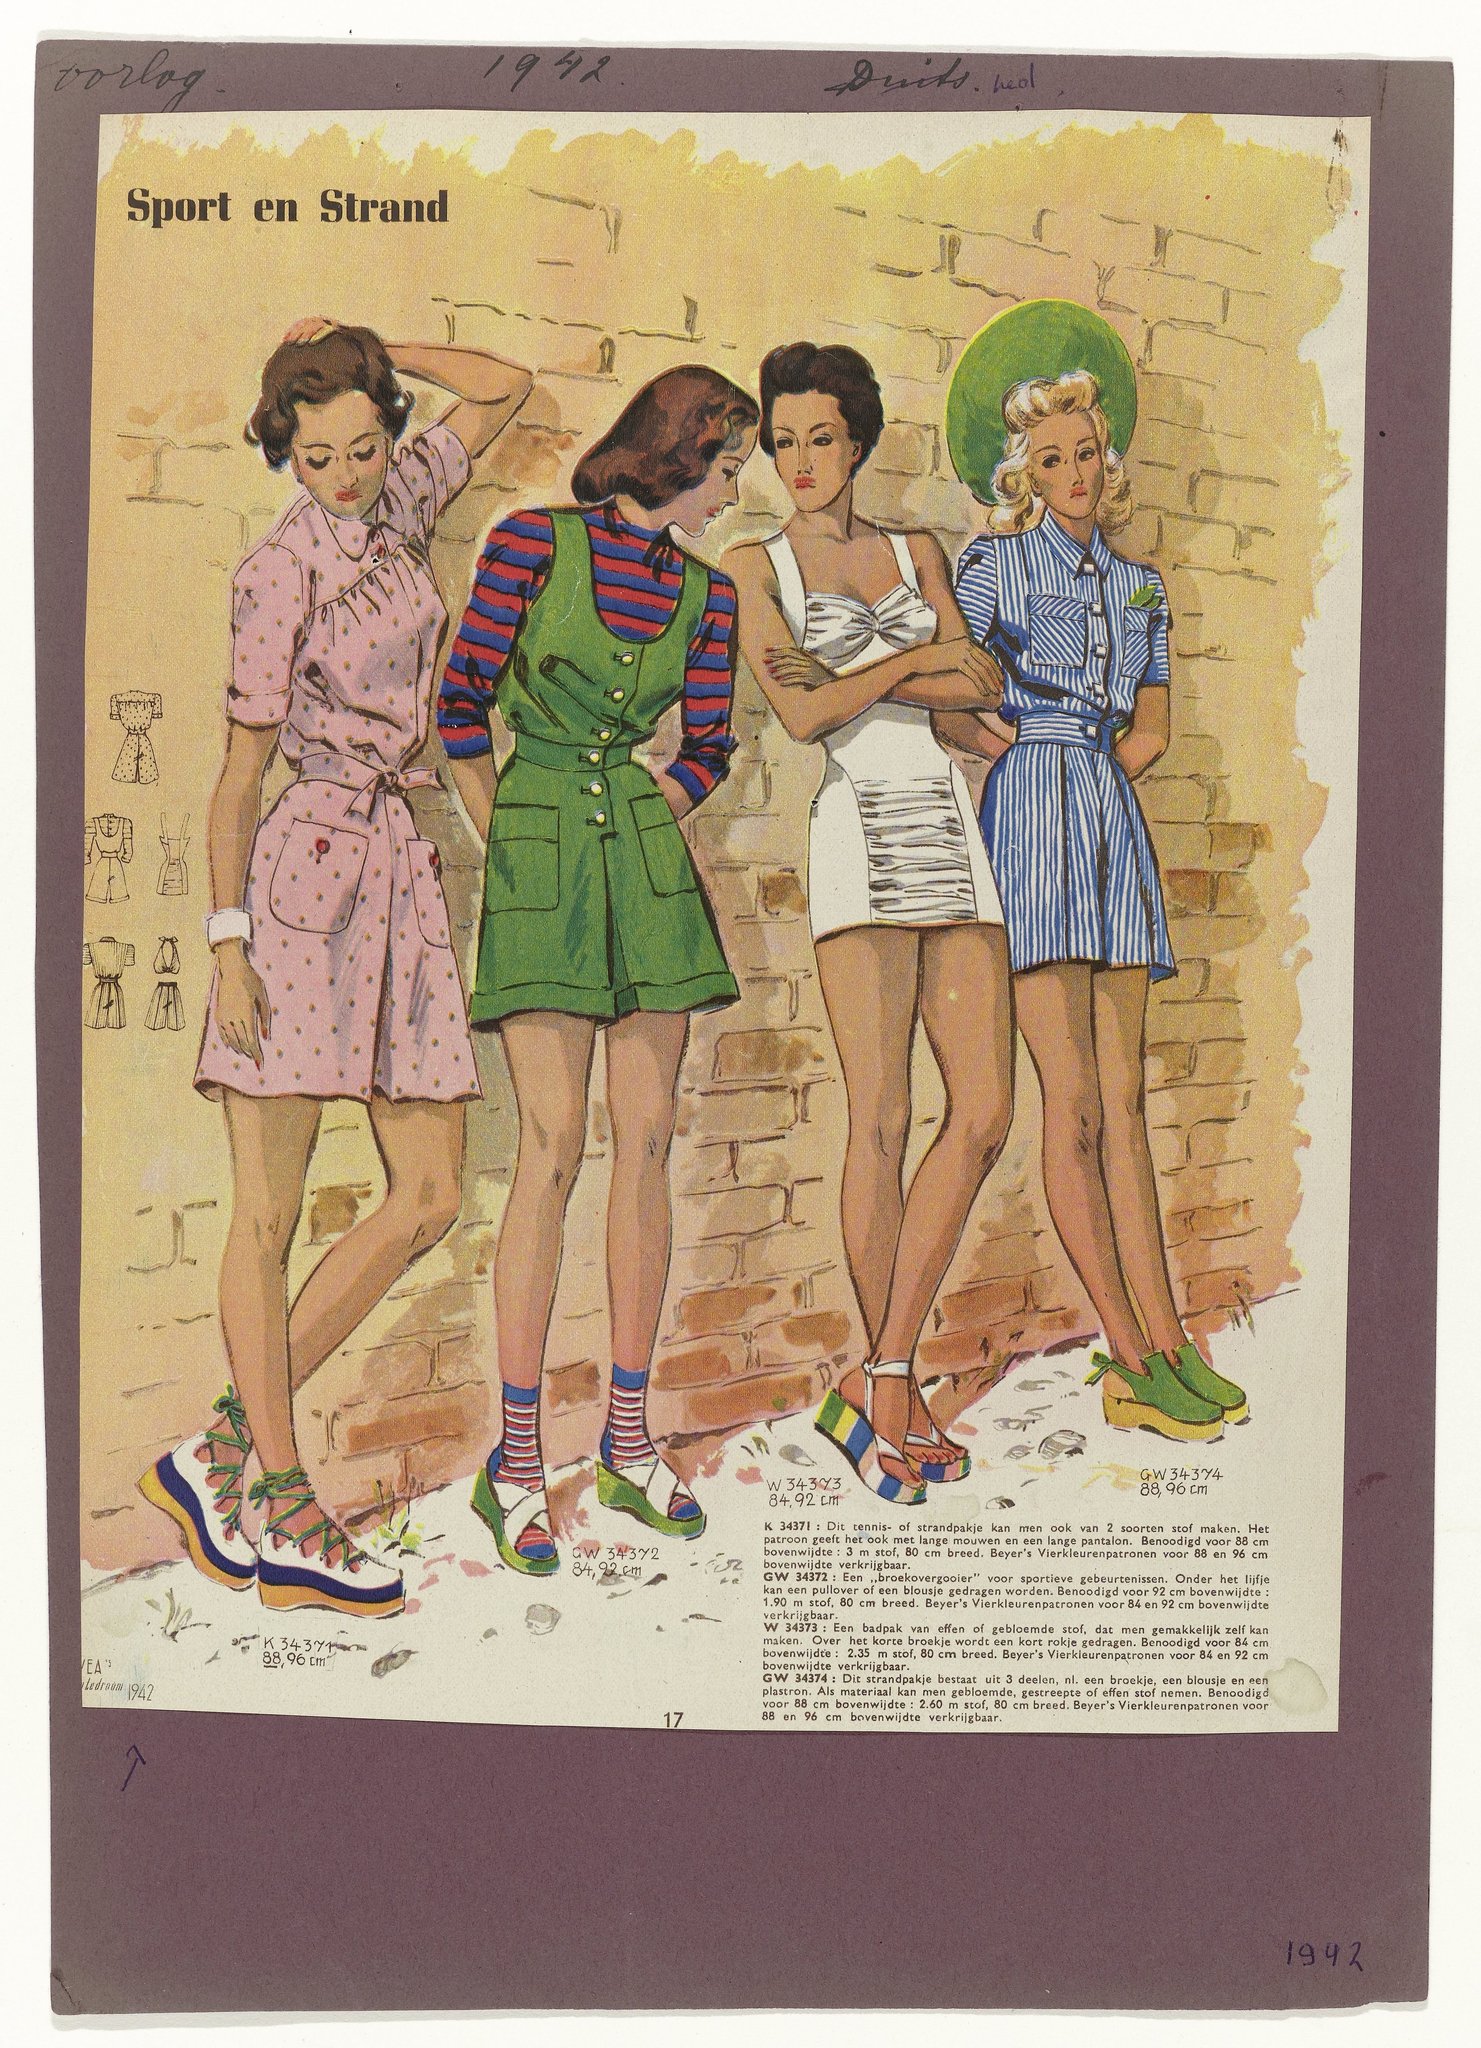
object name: fashion print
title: Sport en strand: K 34371 : Dit tennis- of strandpakj (...)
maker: Anonymous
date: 1942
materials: paper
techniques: printing, photochemical processes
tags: head-gear (+ women's clothes), fashion plates, shoes, sandals (+ women's clothes), dress, gown (+ women's clothes)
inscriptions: title: ‘Sport en Strand’, caption: ‘K 34371 : dit tennis- of strandpakje kan men ook van 2 soorten stof maken. Het patroon geeft het ook met lange mouwen en een lange pantalon. Benoodigd voor 88 cm bovenwijdte: 3 m stof, 80 cm breed. Beyer's Vierkleurenpatronen voor 88 en 96 cm bovenwijdte verkrijgbaar. / GW 34372 : Een "broekovergooier" voor sportieve gebeurtenissen. Onder het lijfje kan een pullover of een blousje gedragen worden. Benoodigd voor 92 cm bovenwijdte : 1.90 m stof, 80 cm breed. Beyer's Vierkleurenpatronnen voor 84 en 92 cm bovenwijdte verkrijgbaar. / W 34373 : Een badpak van effen of gebloemde stof, dat men gemakkelijk zelf kan maken. Over het korte broekje wordt een kort rokje gedragen. Benoodigd voor 84 cm bovenwijdte: 2.35 m stof, 80 cm breed. Beyer's Vierkleurenpatronen voor 84 en 92 cm bovenwijdte verkrijgbaar. / GW 34374 L: Dit strandpakje bestaat uit 3 deelen, nl. een broekje, een blousje en een plastron. Als materiaal kan men gebloemde, gestreepte of effen stof nemen. Benoodigd voor 88 cm bovenwijdte: 2.60 m stof, 80 cm breed. Beyer's Vierkleurenpatronen voor 88 en 96 cm bovenwijdte verkrijgbaar.’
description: Van links naar rechts: tennis- of strandpakje, "broekovergooier", badpak en een strandpakje. [Verso modellen met kleding van o.a. Callot Soeurs, France Obré, Claire Comte enz.]